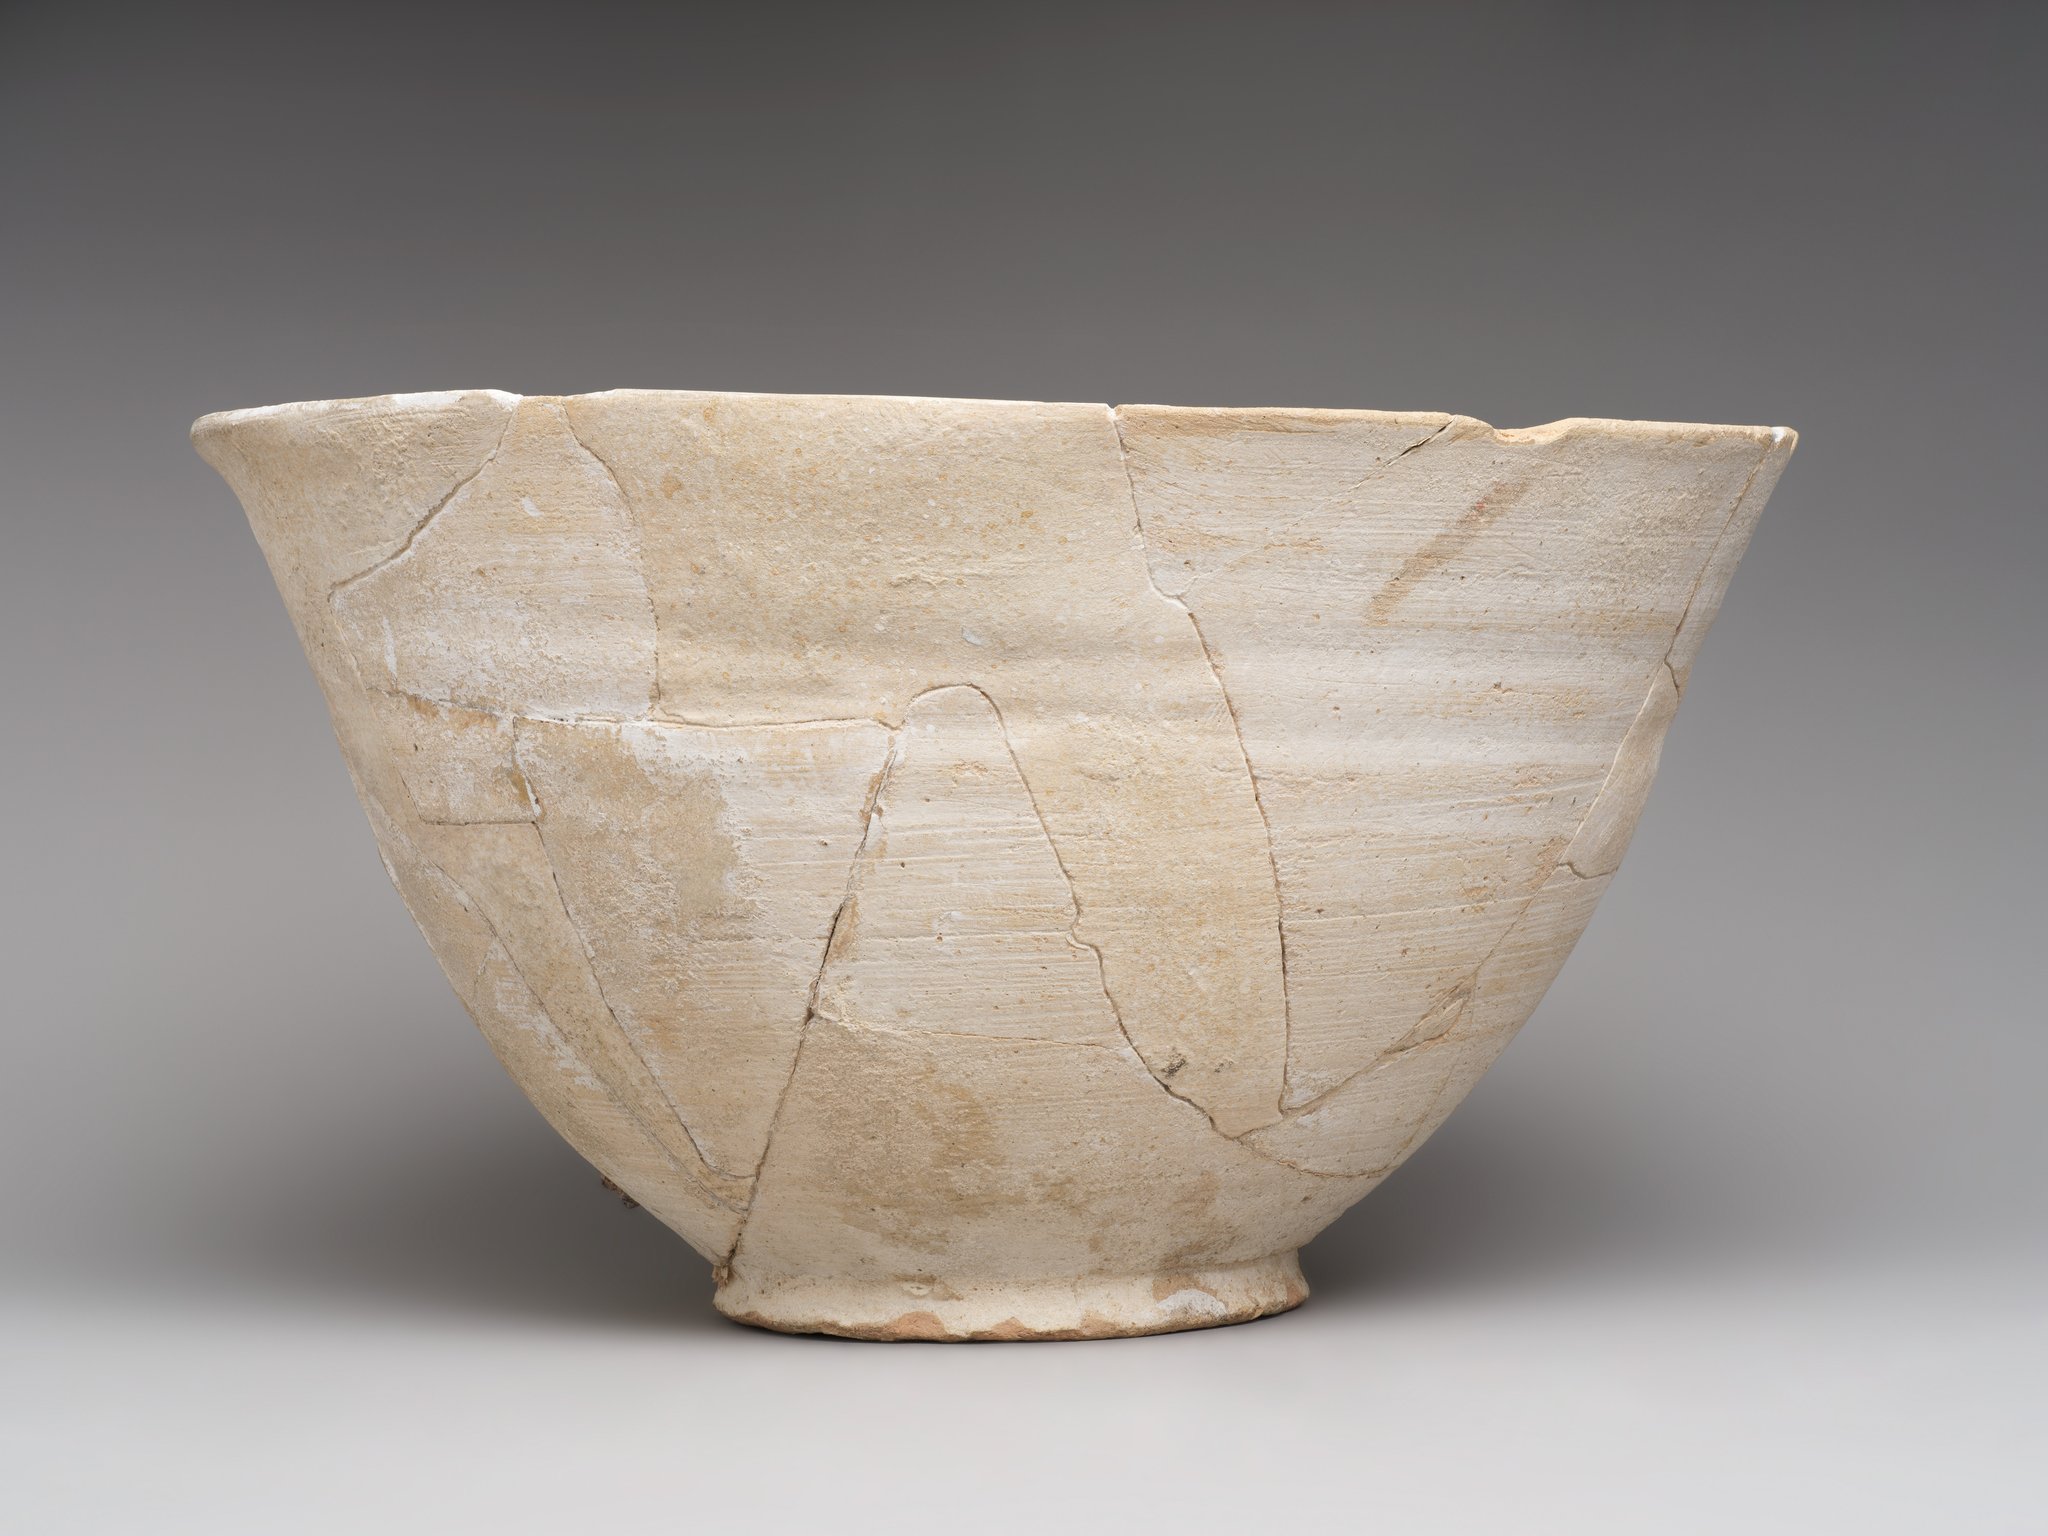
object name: bowl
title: Glazed bowl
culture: sasanian or islamic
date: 501-800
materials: ceramic, glaze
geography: iran